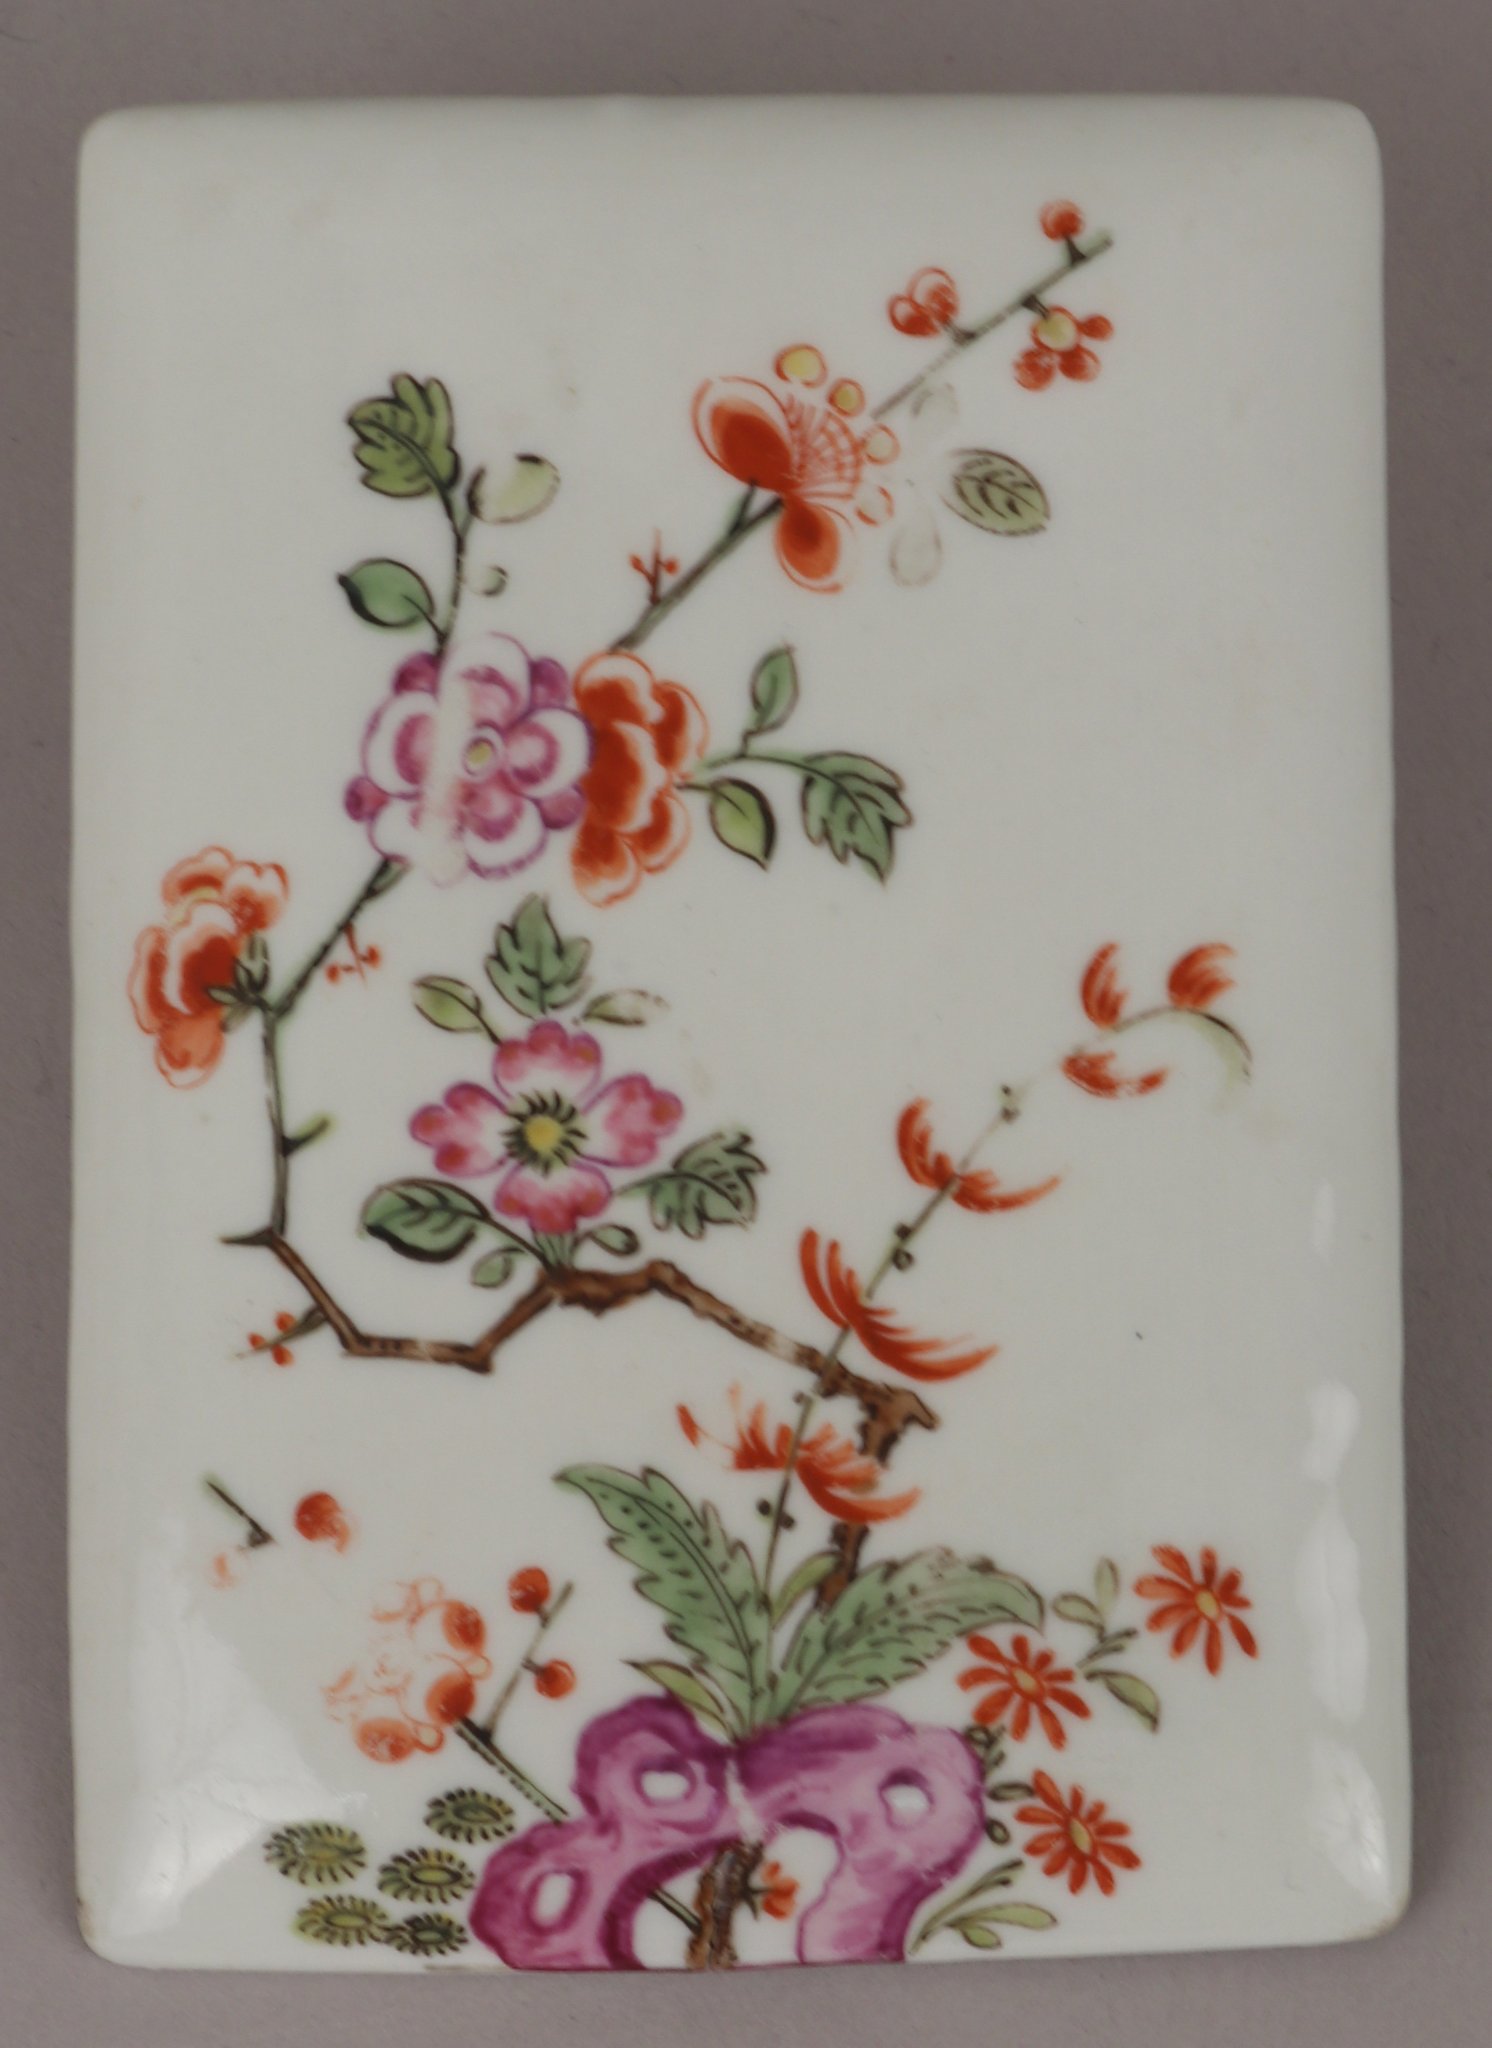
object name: plaque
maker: vienna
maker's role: manufactory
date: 1725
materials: hard paste porcelain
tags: flowers,leaves